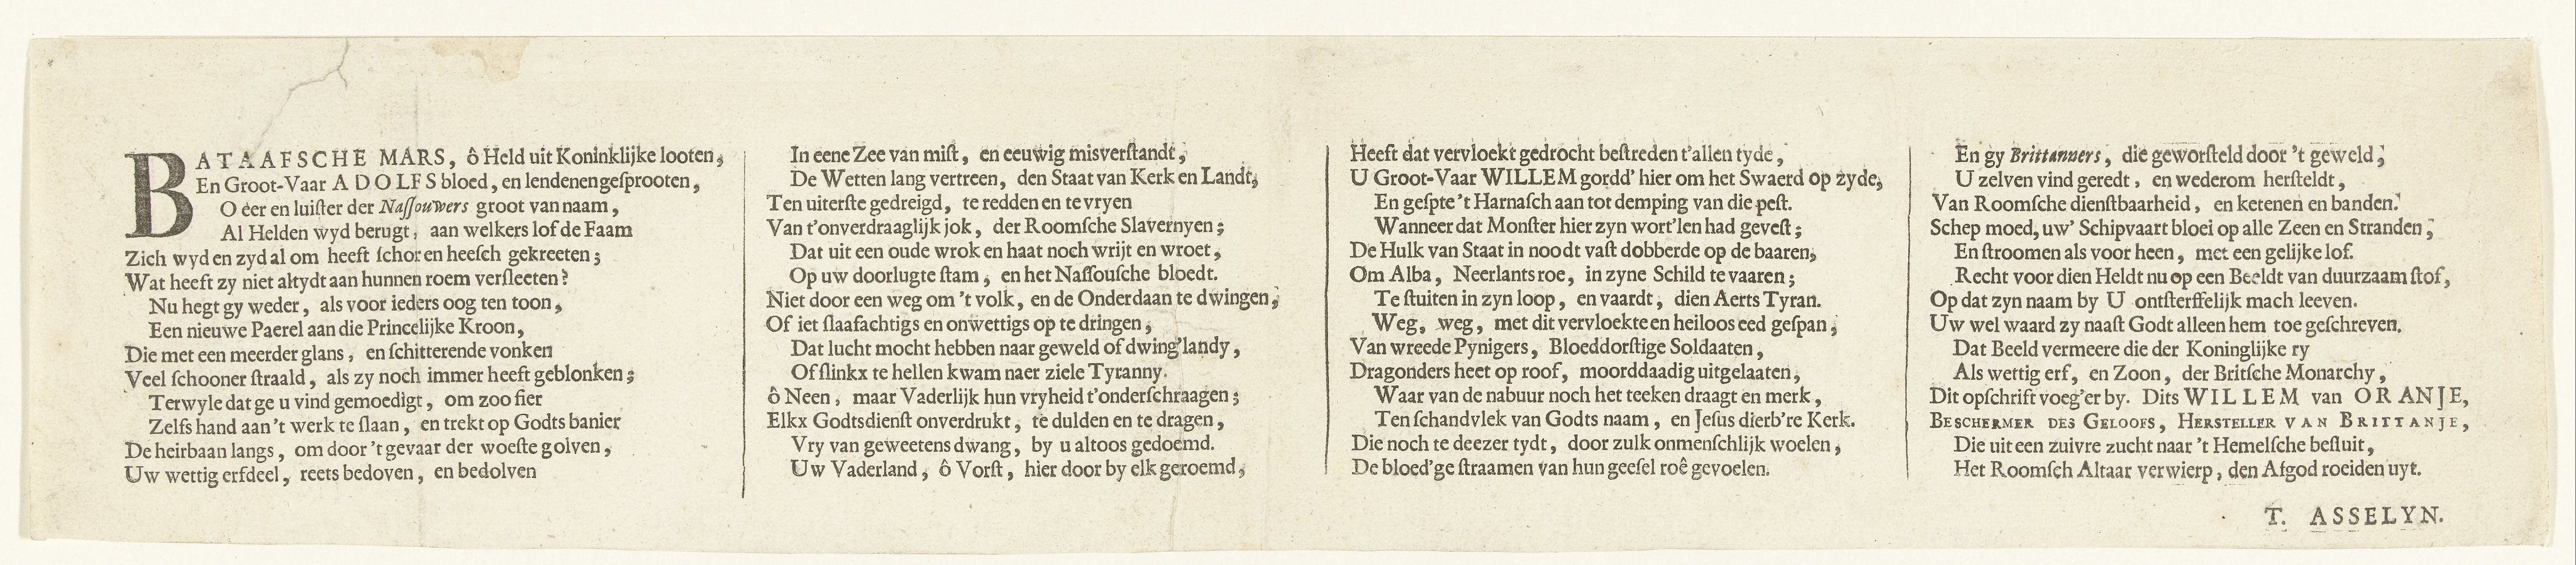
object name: propagandaprent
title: Vers bij de allegorie op het herstel van de ware godsdienst in Engeland met de komst van de prins van Oranje, 1688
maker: thomas asselijn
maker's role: dichter, schrijver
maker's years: 1620-1701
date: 1688-1689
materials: paper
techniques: letterpress printing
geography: northern netherlands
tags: the hague, william iii (prince of orange and king of england, scotland, and ireland)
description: Tekstblad met een vers in vier kolommen, behorend bij de prent met de allegorie op het herstel van de ware godsdienst in Engeland met de komst van de prins van Oranje, 1688.